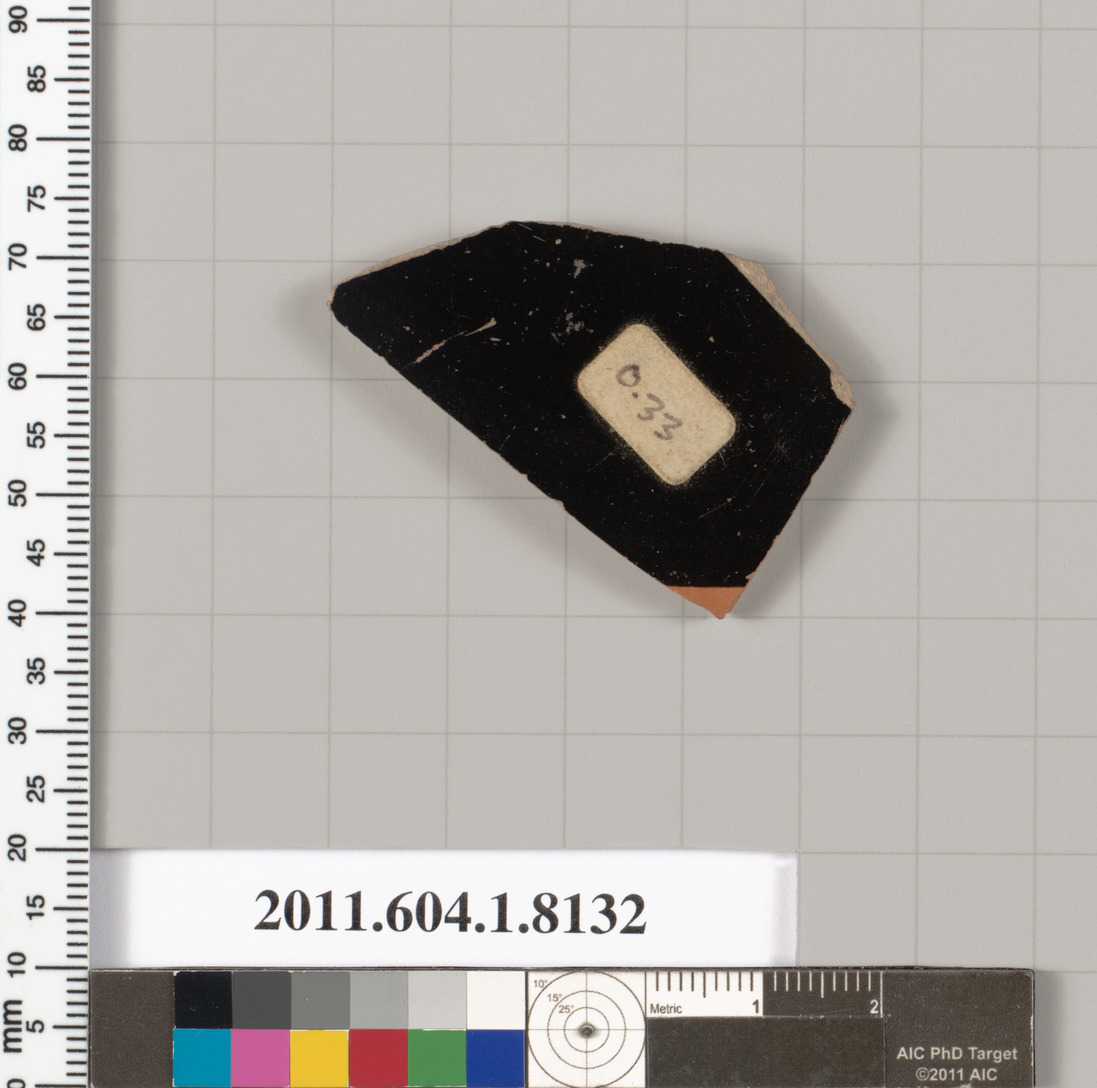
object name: kylix fragment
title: Terracotta fragment of a kylix (drinking cup)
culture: greek, attic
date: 534-468 BCE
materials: terracotta